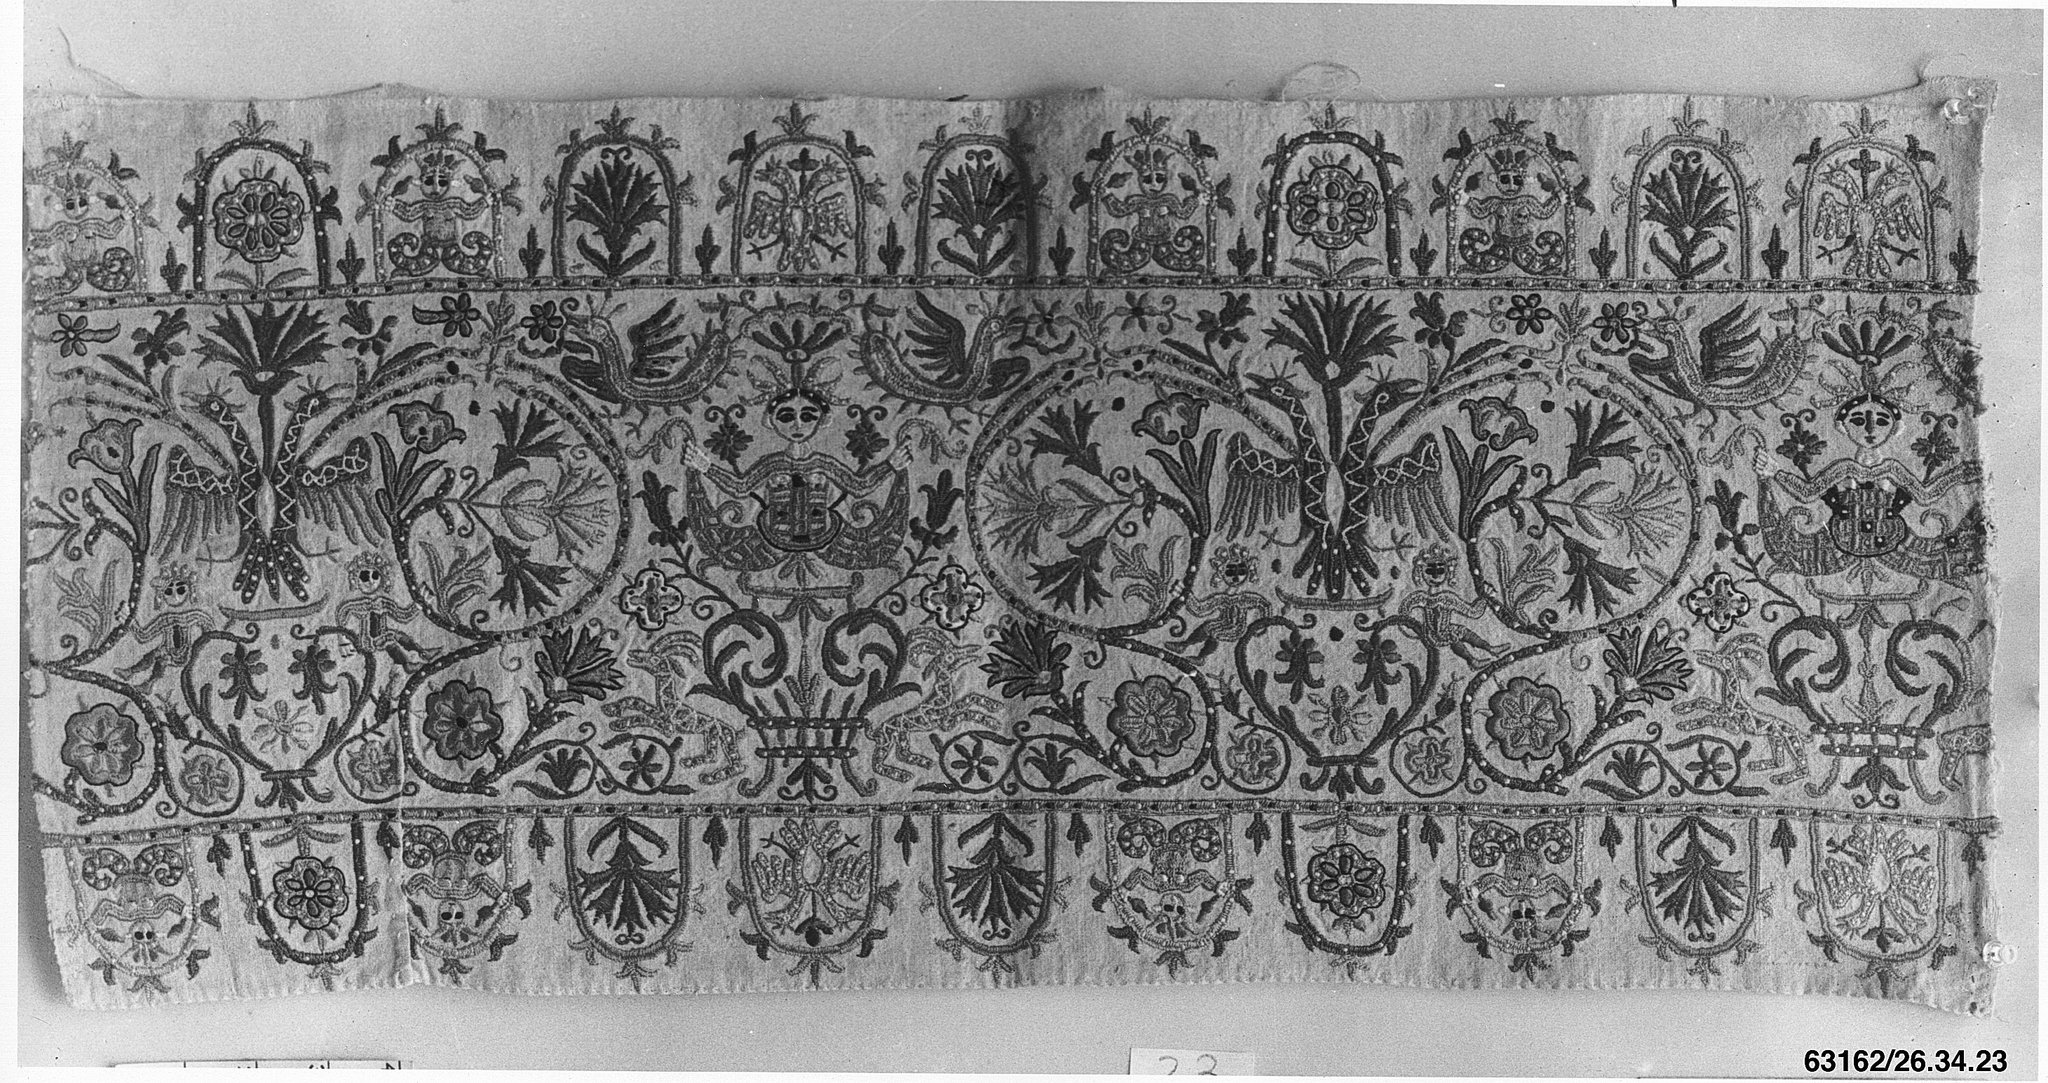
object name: border fragment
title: Portion of a dress border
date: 1701-1800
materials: linen, silk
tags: eagles,flowers